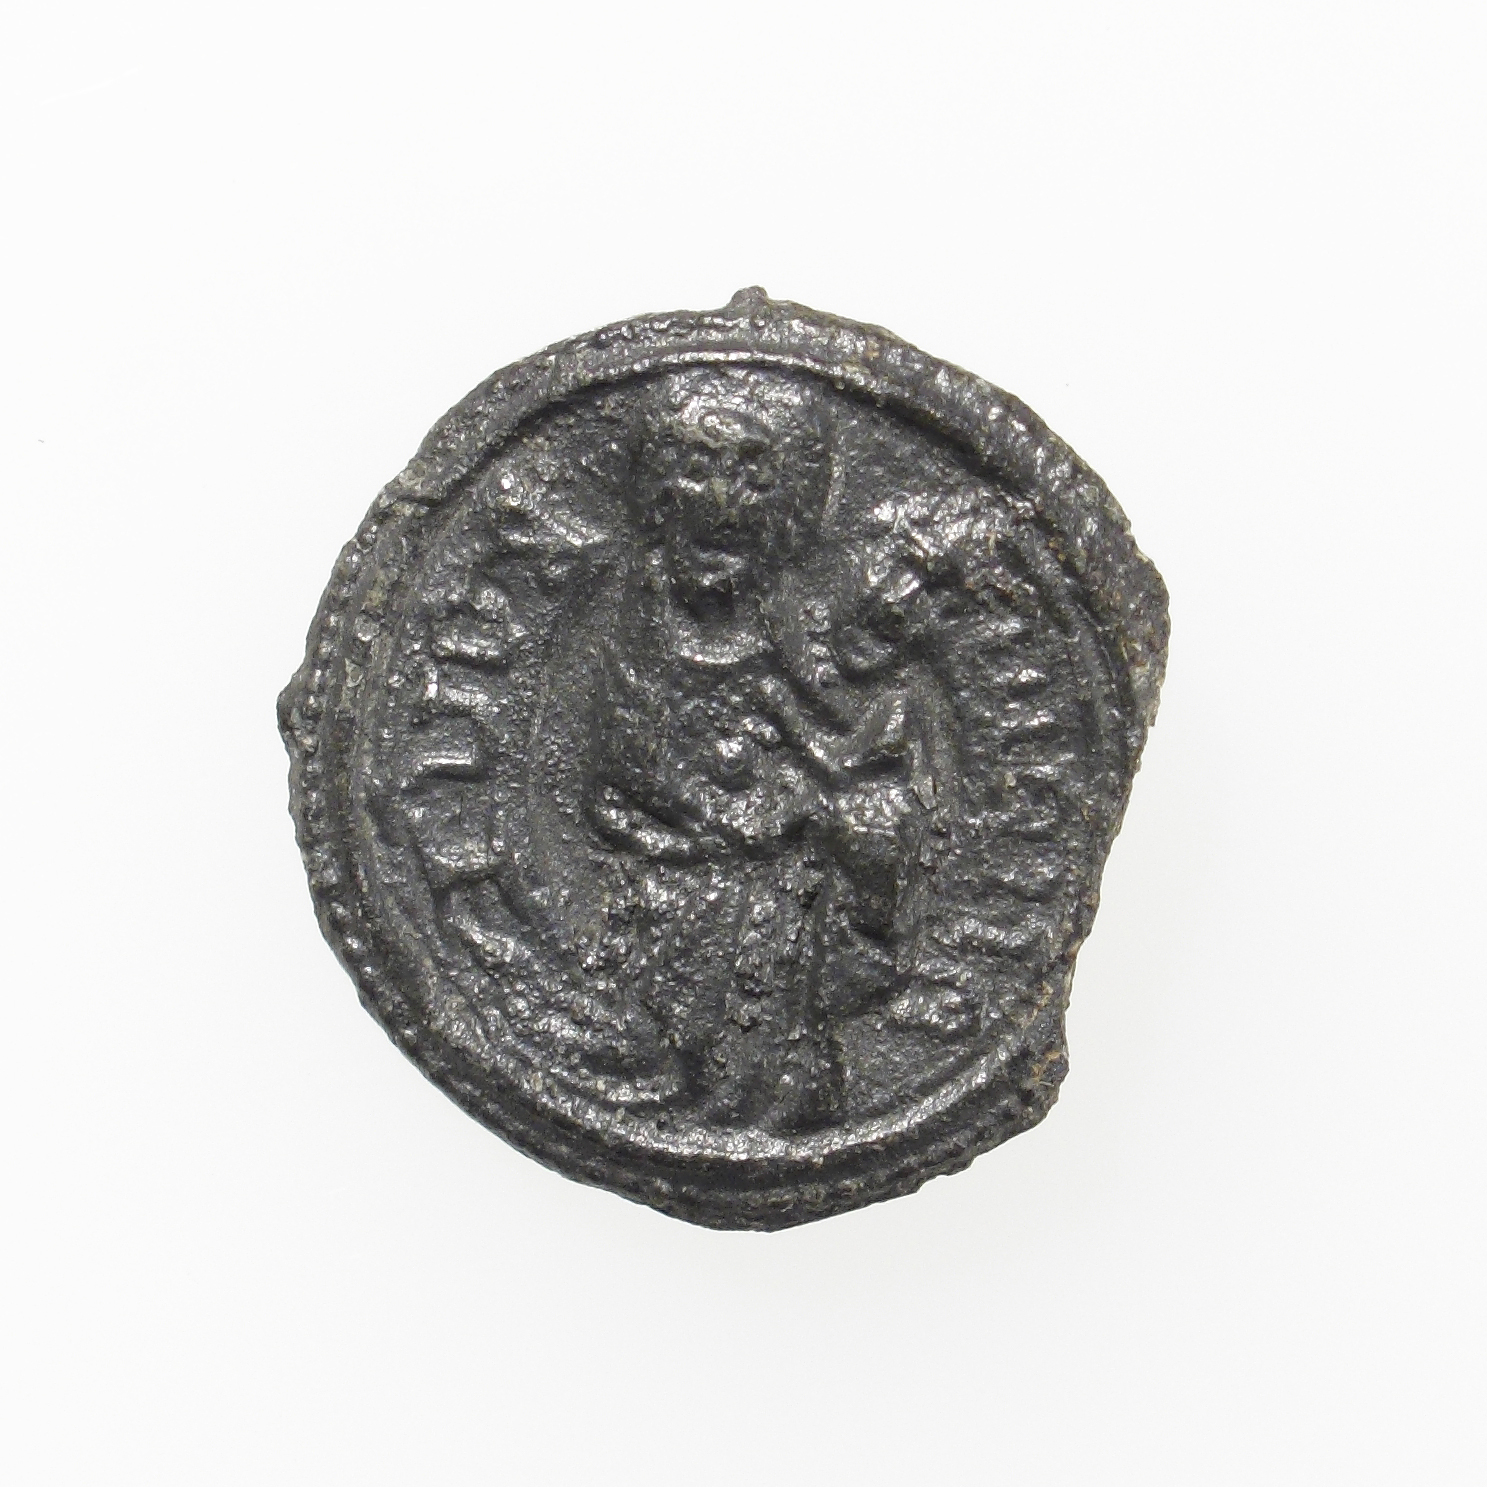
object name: pilgrim's badge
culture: french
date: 1301-1600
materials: lead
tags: madonna and child